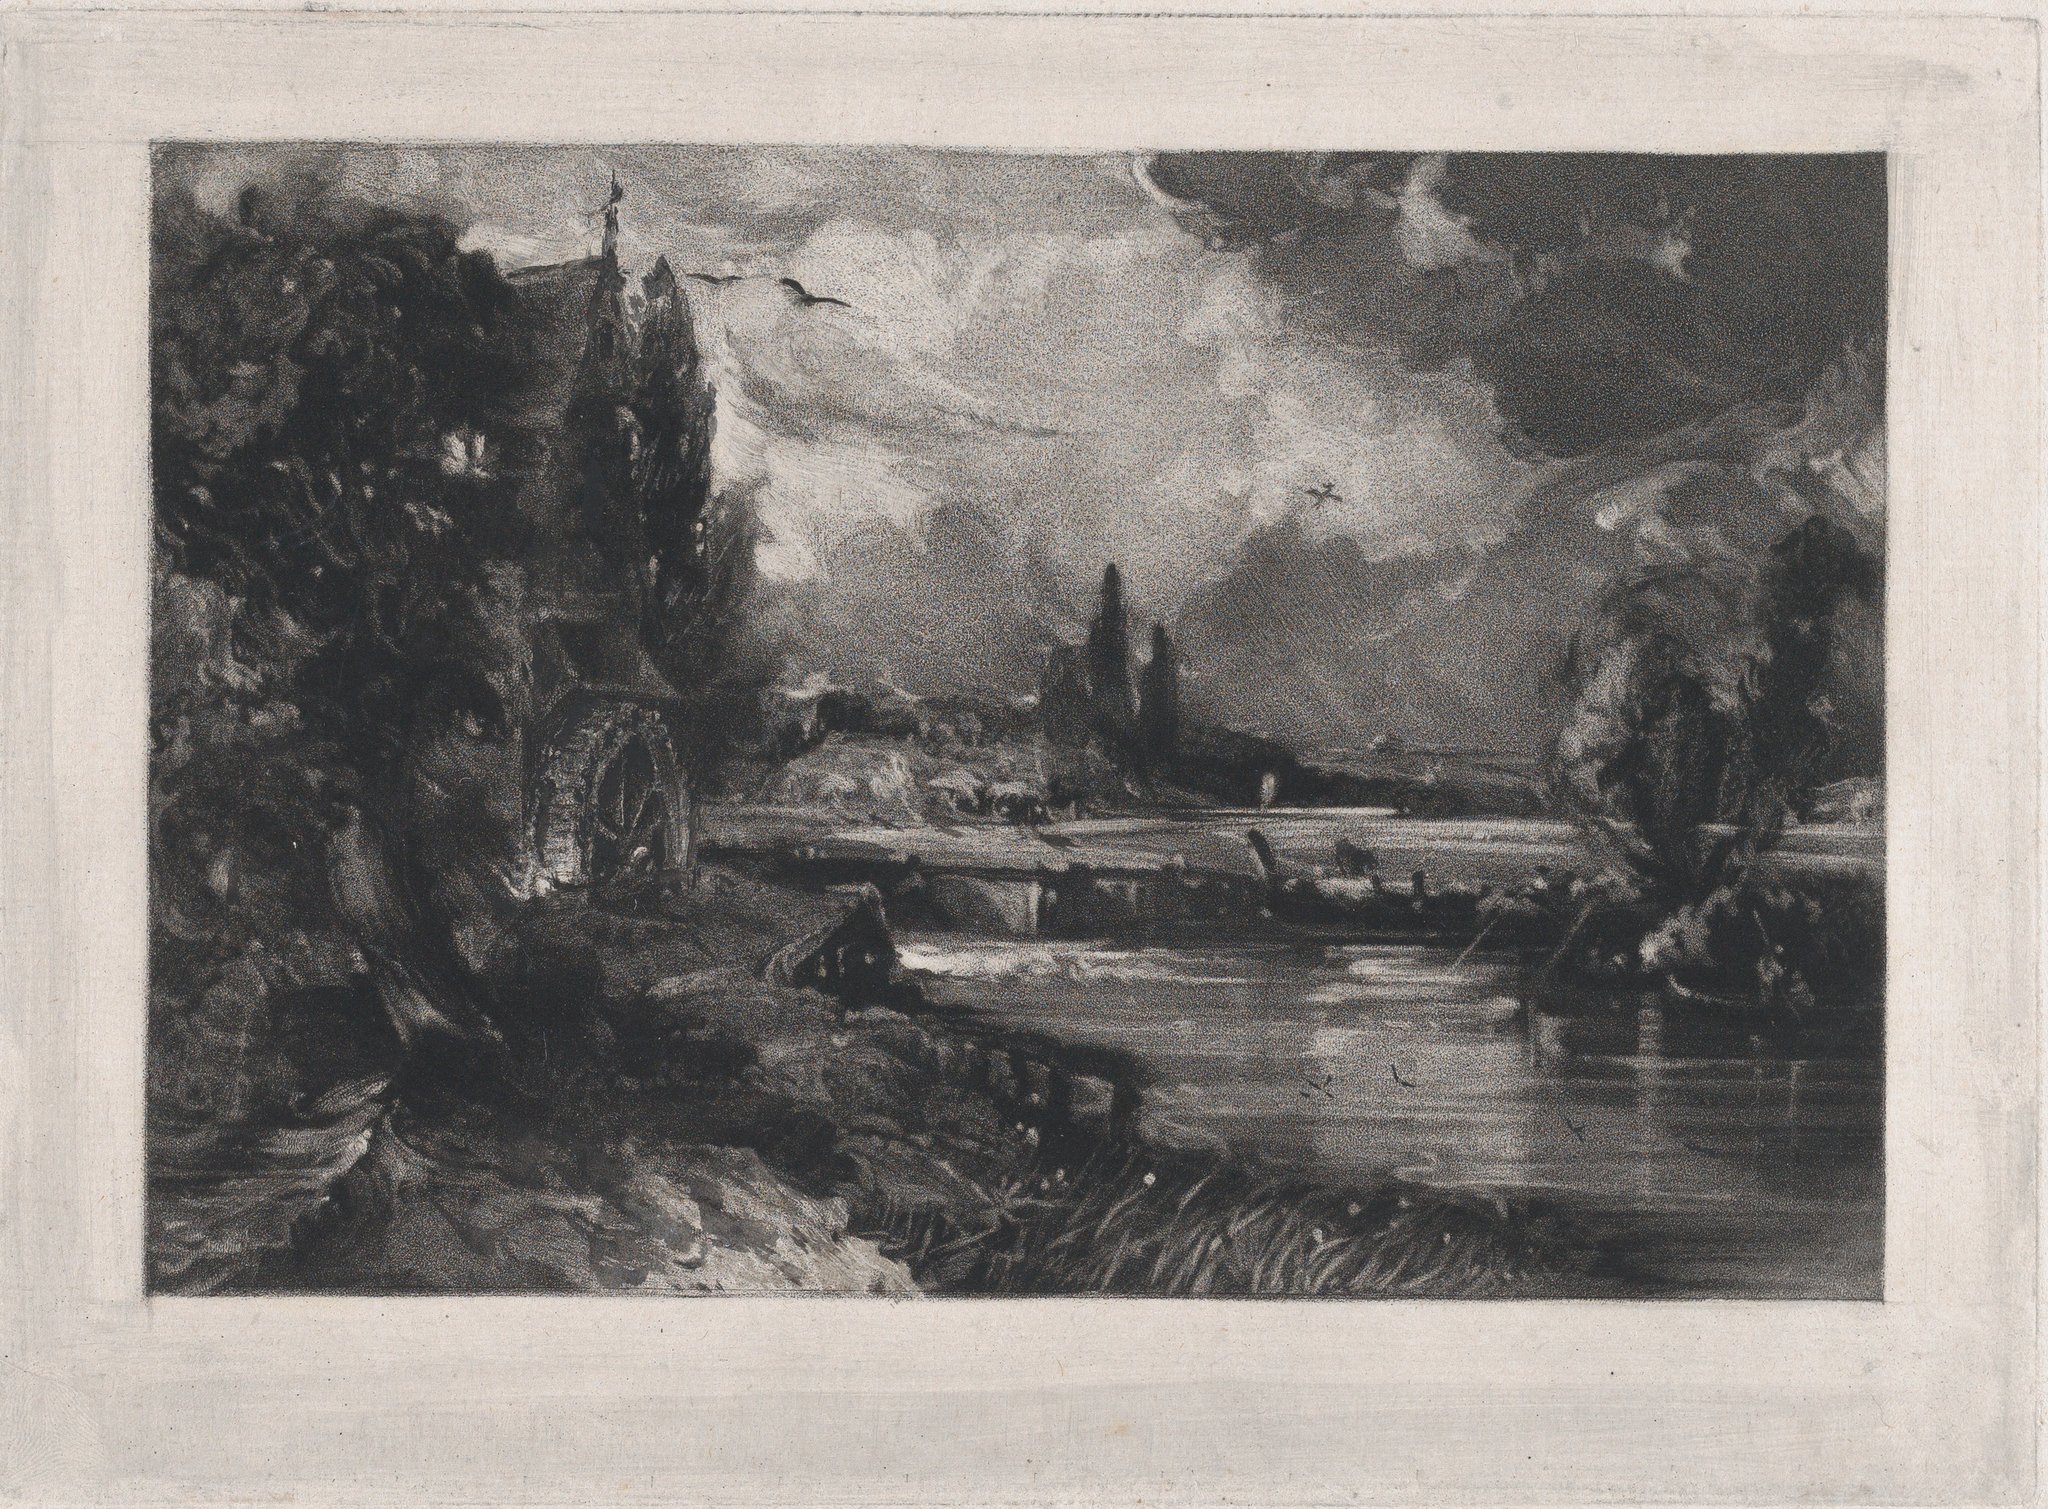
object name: print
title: A Mill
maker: david lucas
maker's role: artist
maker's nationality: british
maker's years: 1802-1881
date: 1829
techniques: mezzotint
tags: watermills,landscapes